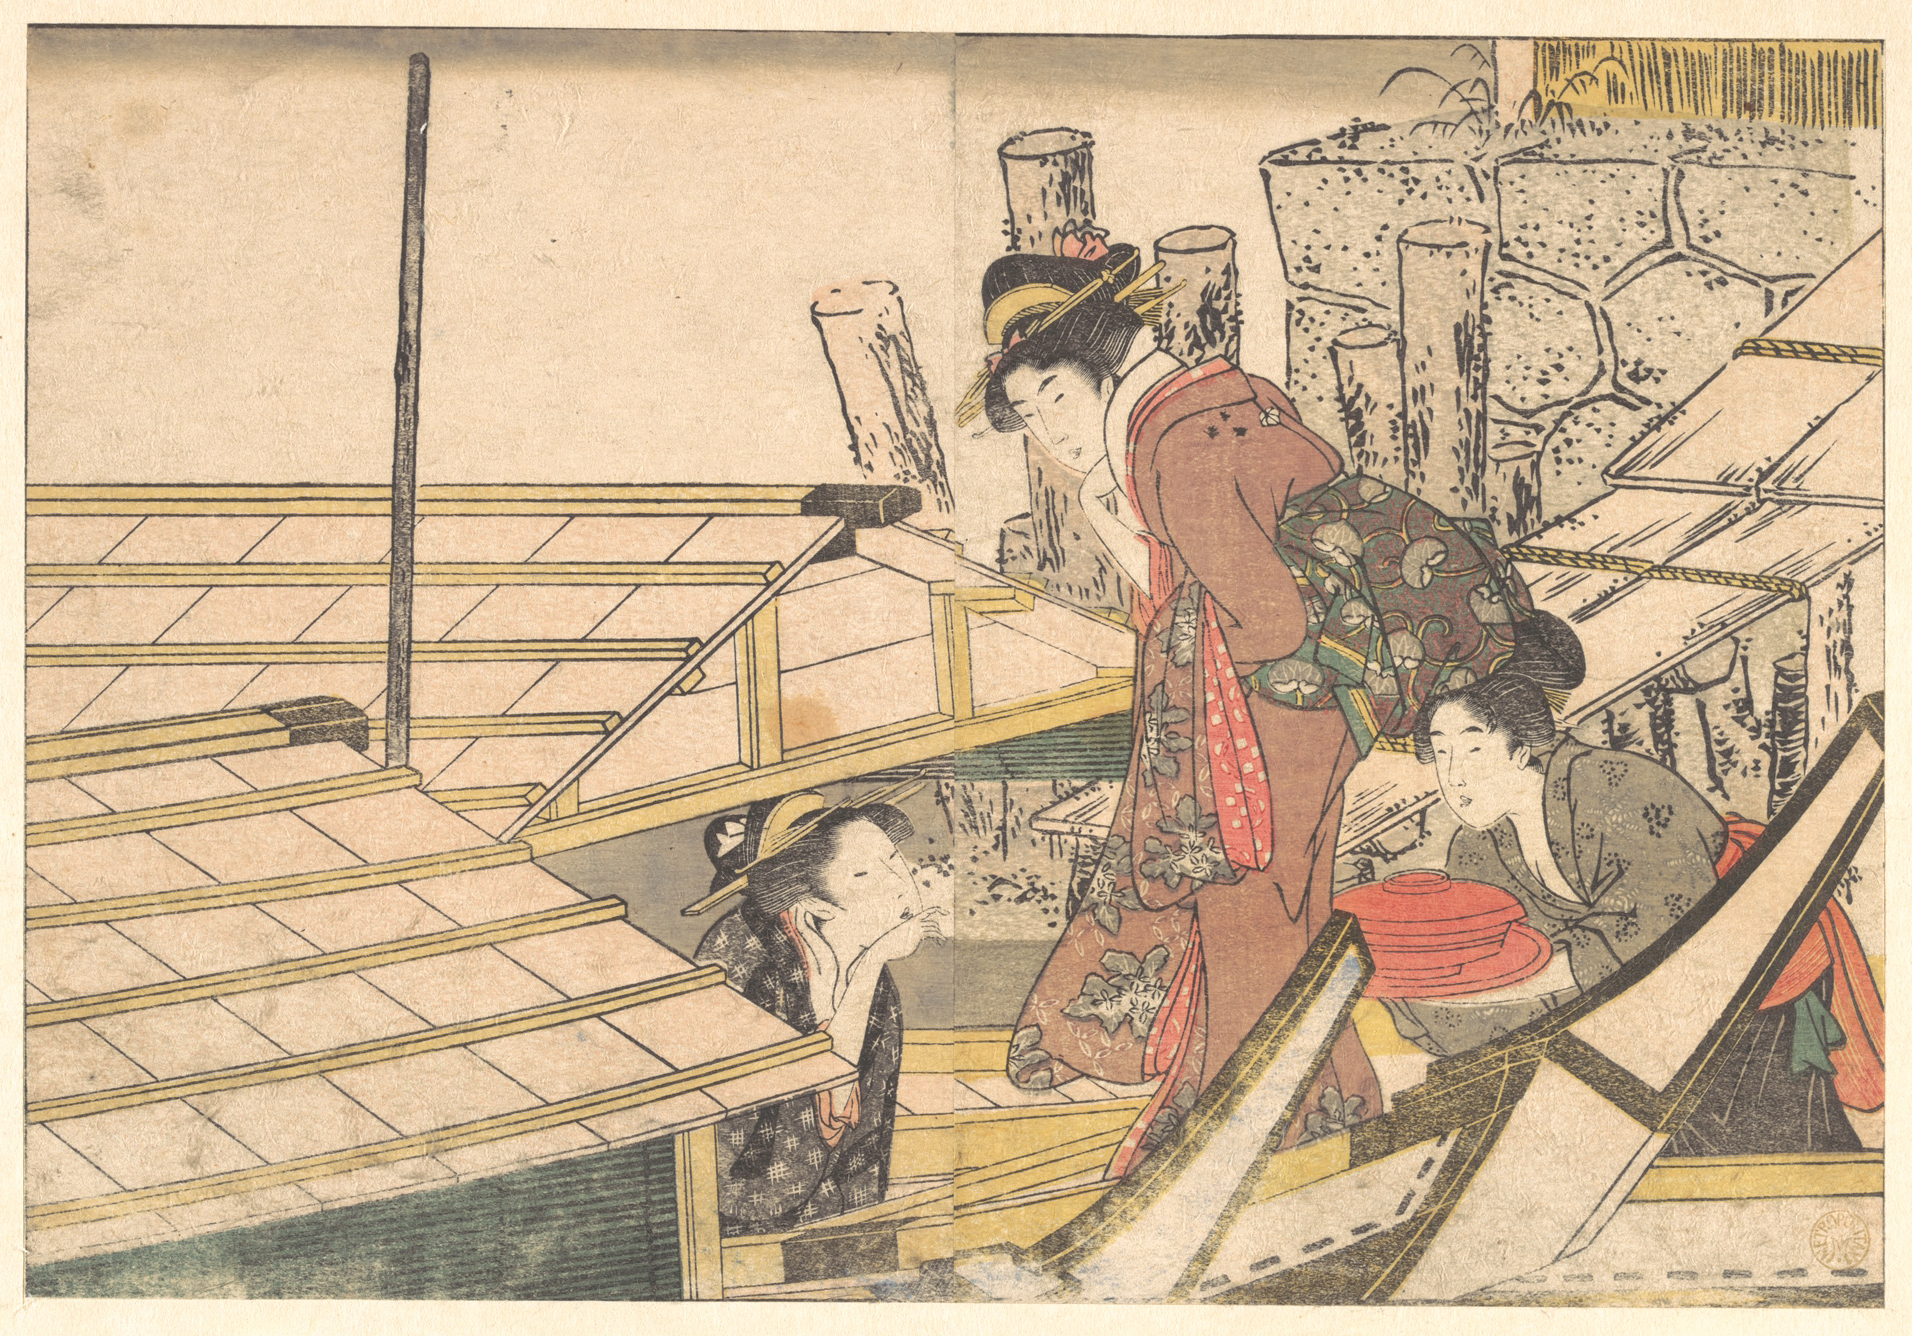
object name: woodblock print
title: Girls Getting on Board a Boat, from the illustrated book Flowers of the Four Seasons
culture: japanese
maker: kitagawa utamaro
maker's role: artist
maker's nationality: japanese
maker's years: 1754-1806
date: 1801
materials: ink, paper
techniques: woodblock print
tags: girls,boats